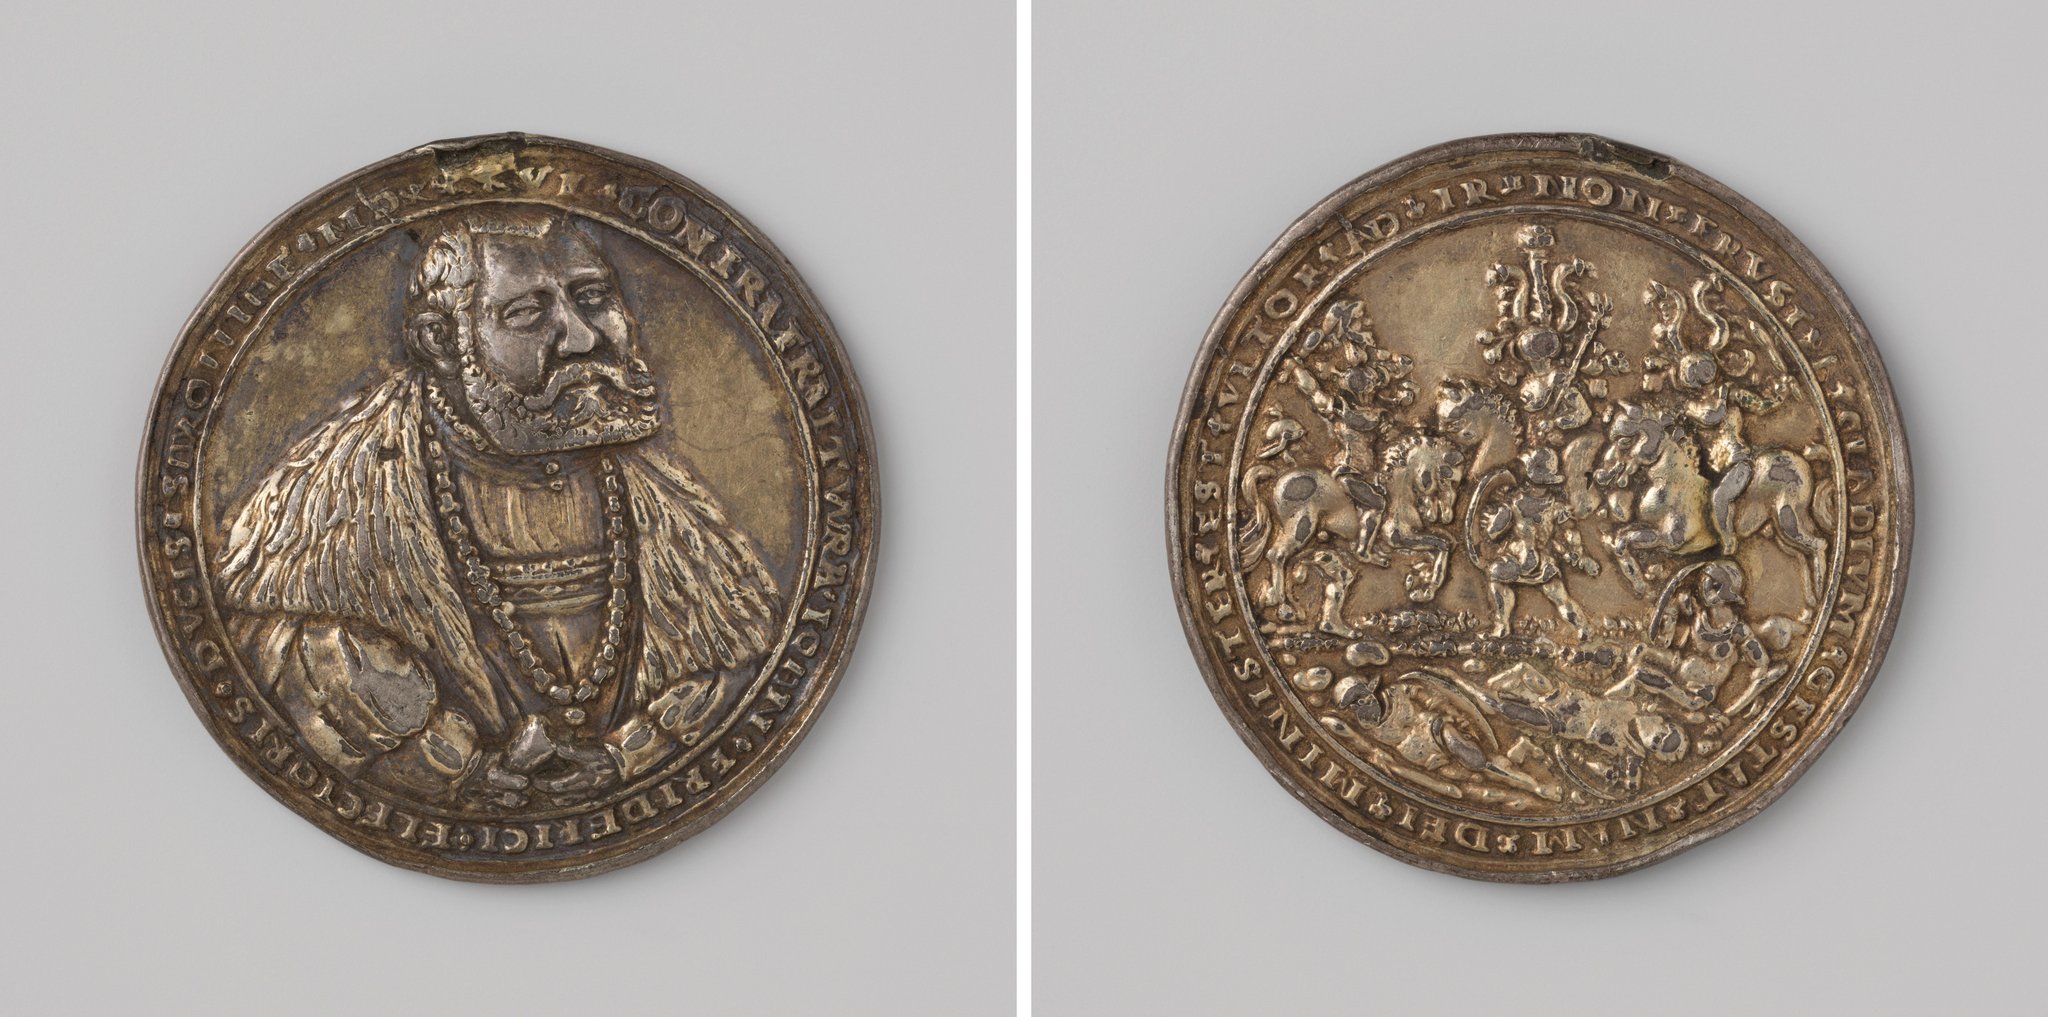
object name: history medal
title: Johan Frederik de Grootmoedige, keurvorst van Saksen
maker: wolf milicz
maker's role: medailleur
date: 1536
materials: silver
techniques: casting, gilding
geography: germany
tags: torgau, weimar, johan frederik i (keurvorst van saksen)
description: Zilveren penning, draagoog afgebroken. Voorzijde: borststuk man met handschoen in hand binnen omschrift. Keerzijde: drie ruiters met saksische helmen in gevecht met een soldaat te voet; op de grond twee gedode en een gewonde soldaat binnen omschrift.